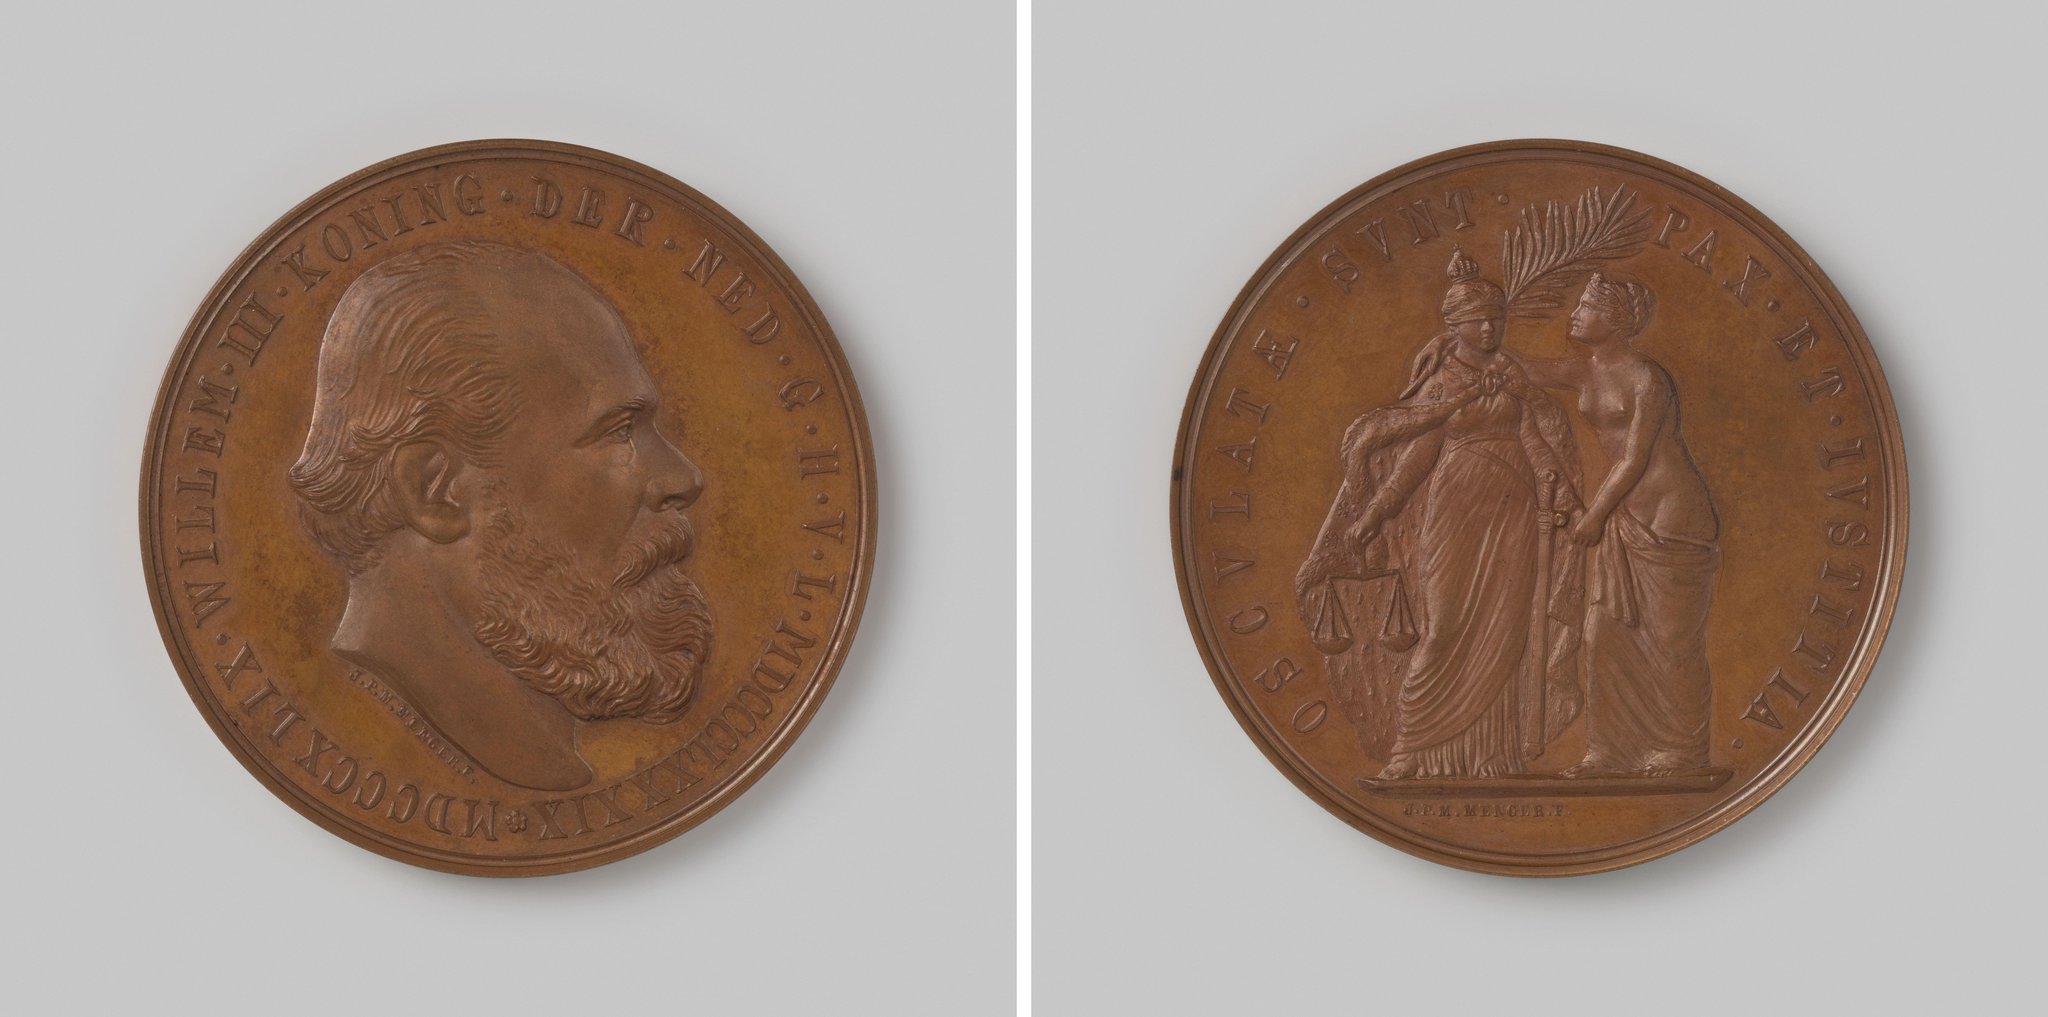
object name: history medal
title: Veertigjarig regeringsjubileum van Koning Willem III 1889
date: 1889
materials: bronze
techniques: striking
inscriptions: factory mark: ‘mercuriusstaf’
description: Bronzen penning, op de voorzijde het portret van Willem III naar rechts met omschrift, op de keerzijde de Vrede, met palmtak, die de Gerechtigheid, met blinddoek, weegschaal en zwaard, de Nederlandse koningsmantel omhangt, met omschrift.